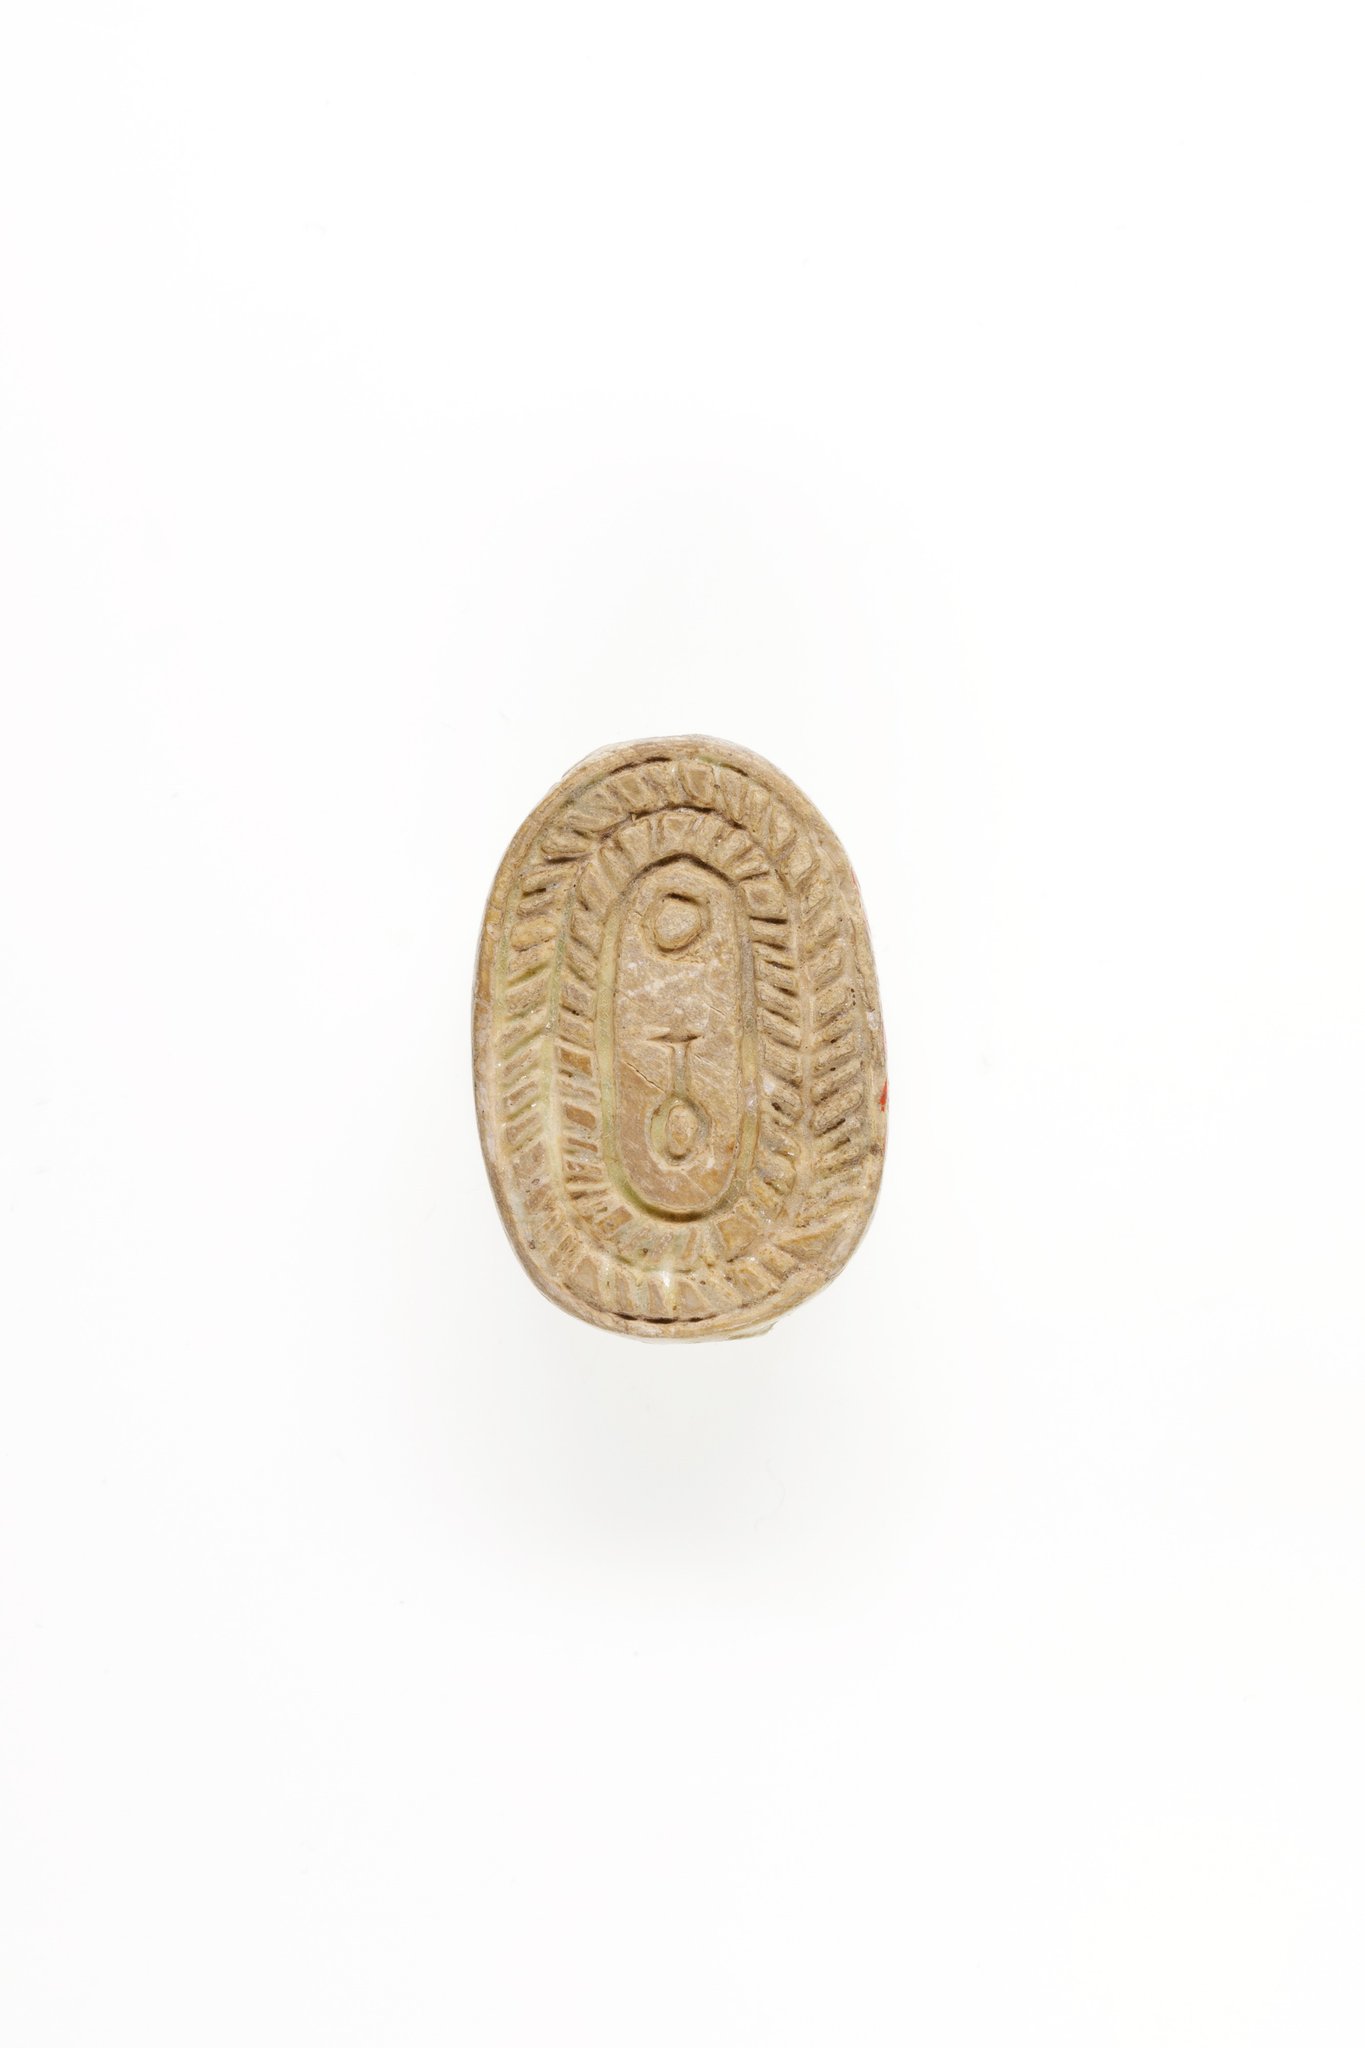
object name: scarab, nefer re, rope border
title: Scarab Inscribed with Hieroglyphs in a Rope Border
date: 1740-1640 BCE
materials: glaze, stone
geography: egypt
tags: hieroglyphs,scarabs